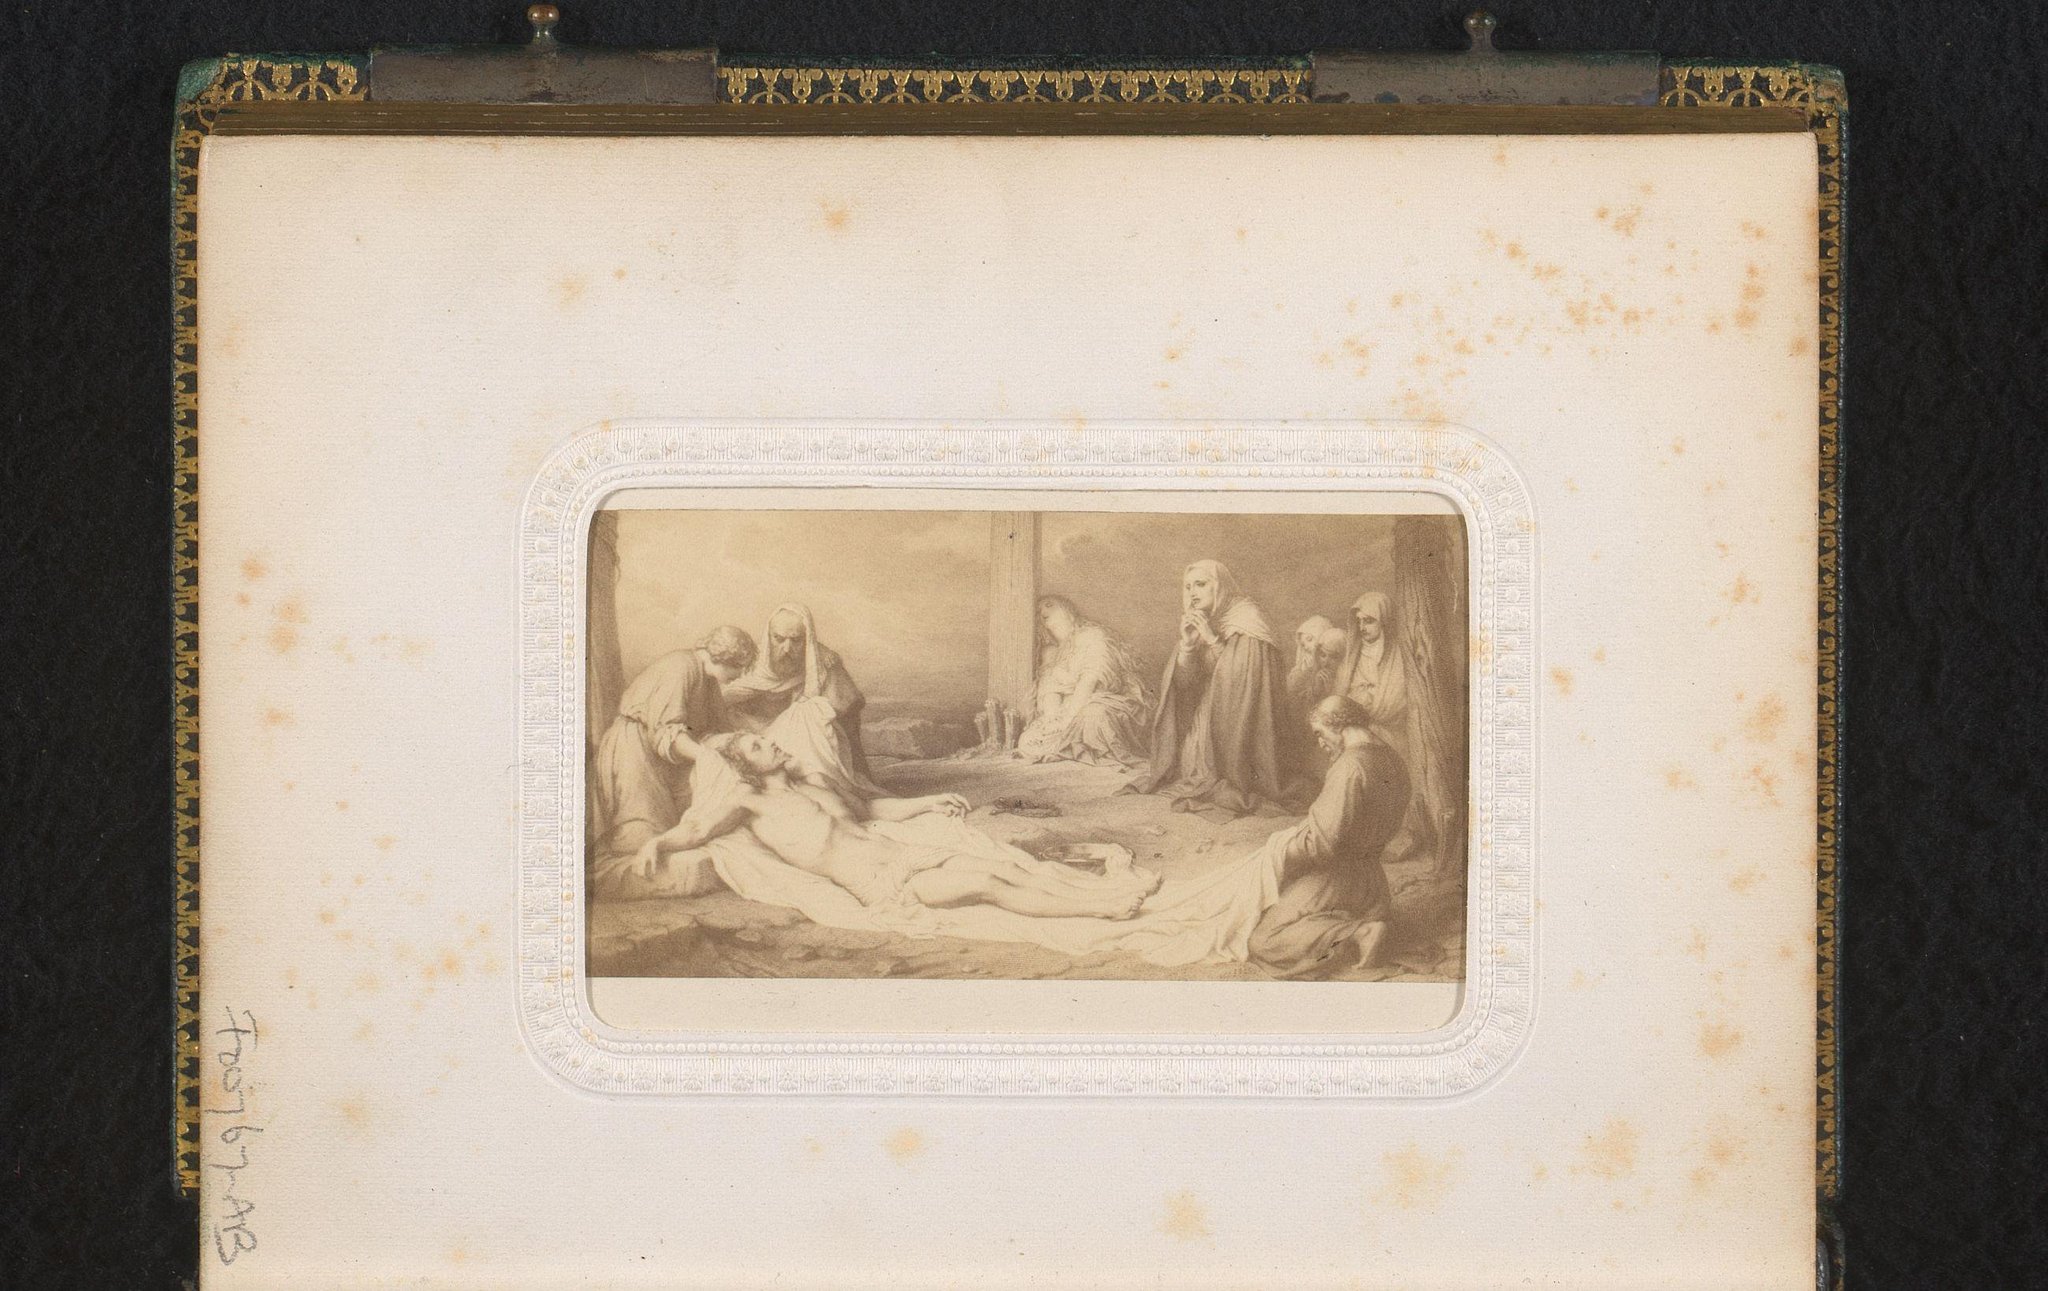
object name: carte de visite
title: Fotoreproductie van een schilderij van de graflegging van Christus door Paul Delaroche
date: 1861-1878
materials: cardboard, photographic support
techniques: albumen print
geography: paris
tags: preparations for christ's entombment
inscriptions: inscription: ‘PHOTOGRAPHIE GOUPIL & Cie/ PARIS, 19, Bd Montmartre./ LONDRES-LA HAYE-BERLIN-NEW YORK.’